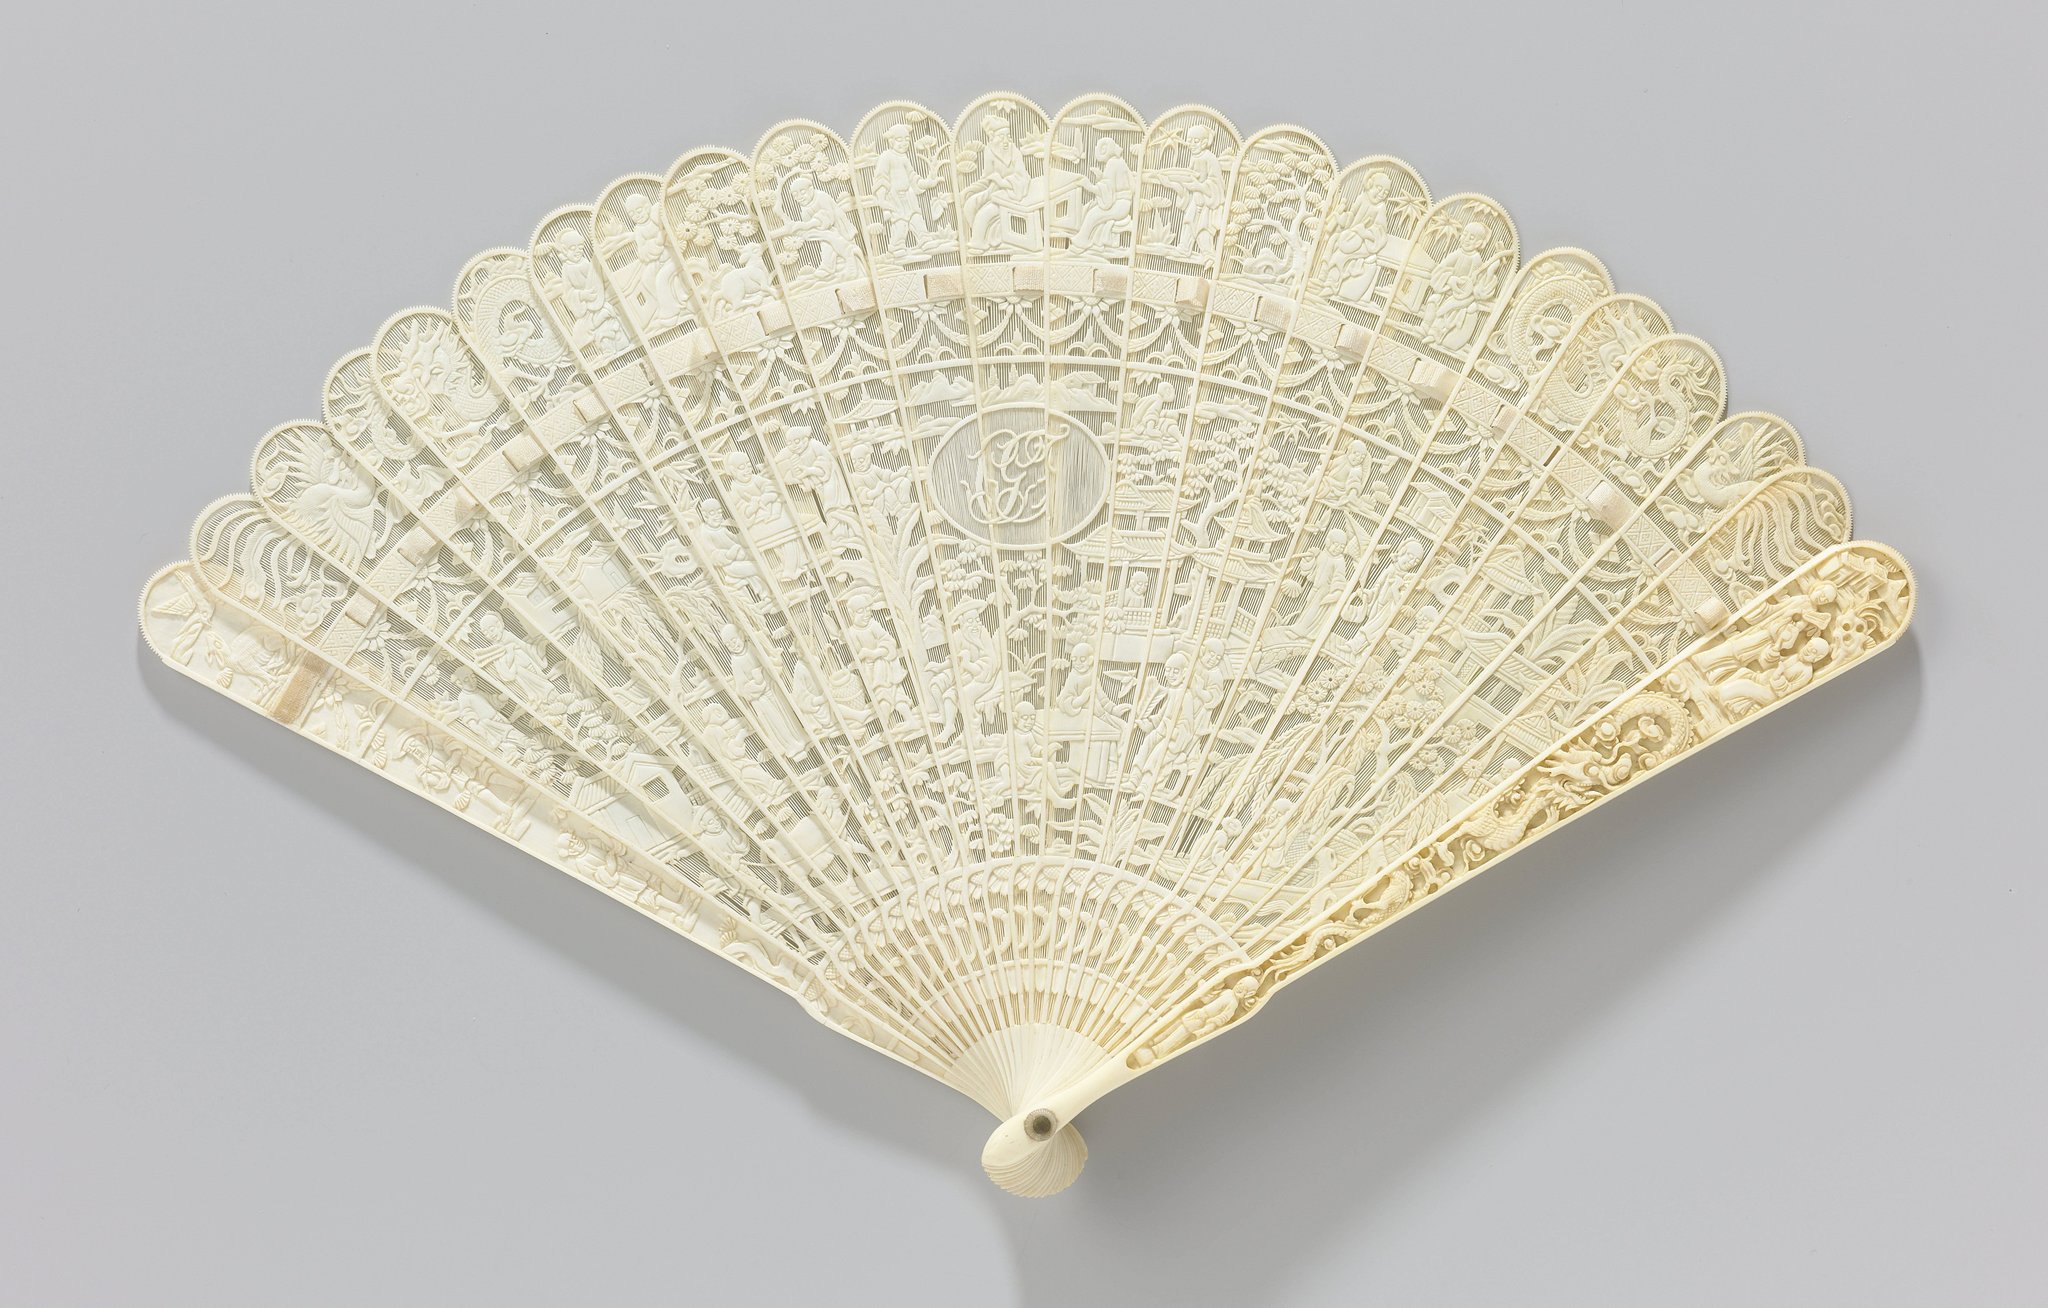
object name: brisé fan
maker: huchang (fychong)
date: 1800-1825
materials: copper, ivory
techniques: cutting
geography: guangdong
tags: chinese (+ other cultural aspects)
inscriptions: initials: ‘C.G.T.’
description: In 1728 the Dutch East India Company set up a trading office in Canton in China. This facilitated the import of Chinese luxury goods into the Netherlands. It was also possible to order custom-made items custom, for example this fan for Cecilia Geertruy Tierens Segersdochter of Zaltbommel. Her initials are visible in the oval medallion.